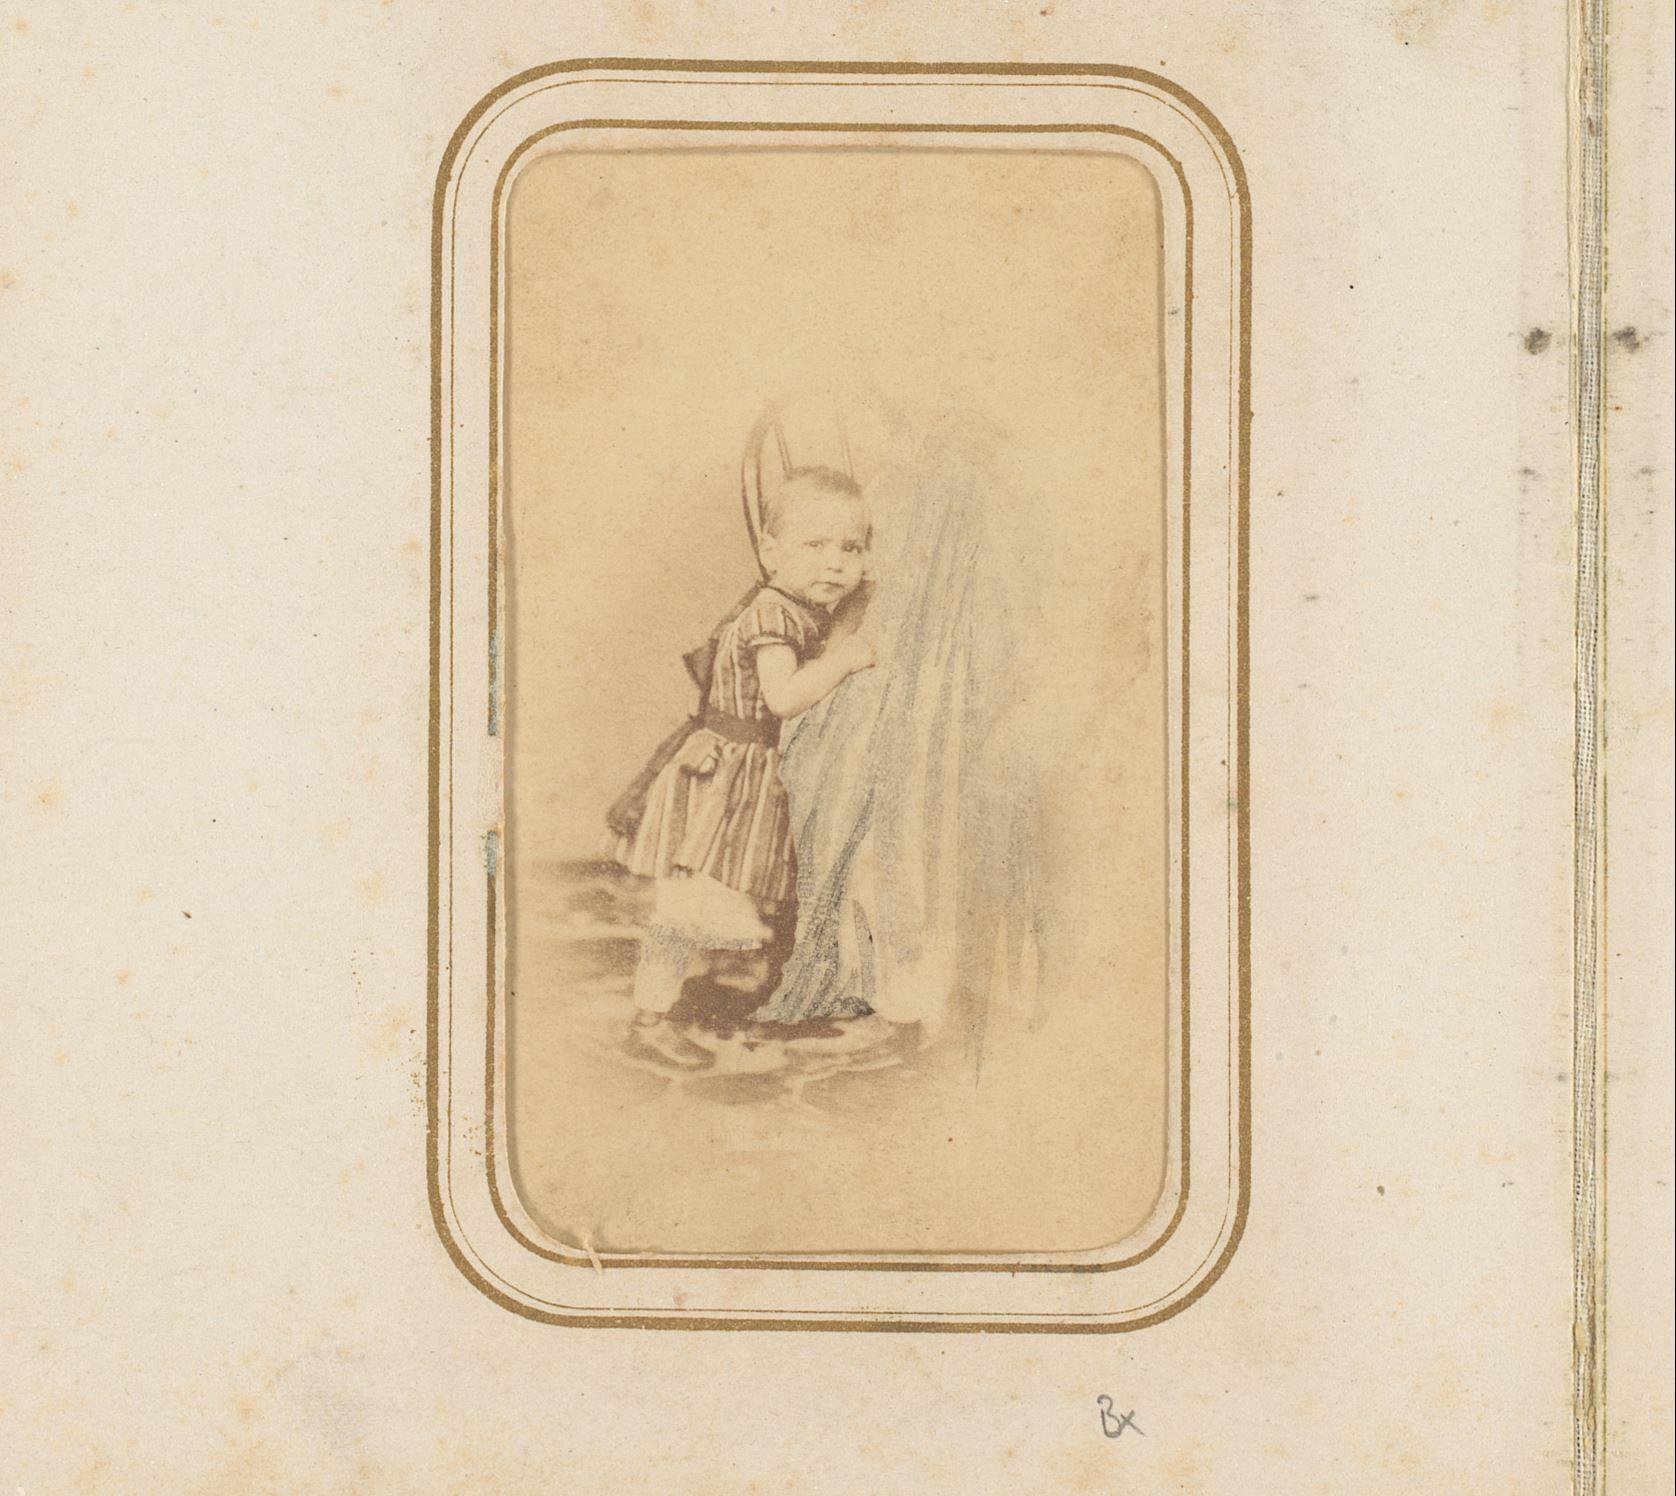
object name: carte de visite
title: Portret van een kind, aangeduid als G.A.M. de Bruine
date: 1870-1880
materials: cardboard, photographic support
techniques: albumen print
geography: batavia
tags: child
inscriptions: inscription: ‘W.J. Olland & Zoon/ Java’, annotation: ‘G.A.M. de Bruine/ oud 3 jaar’